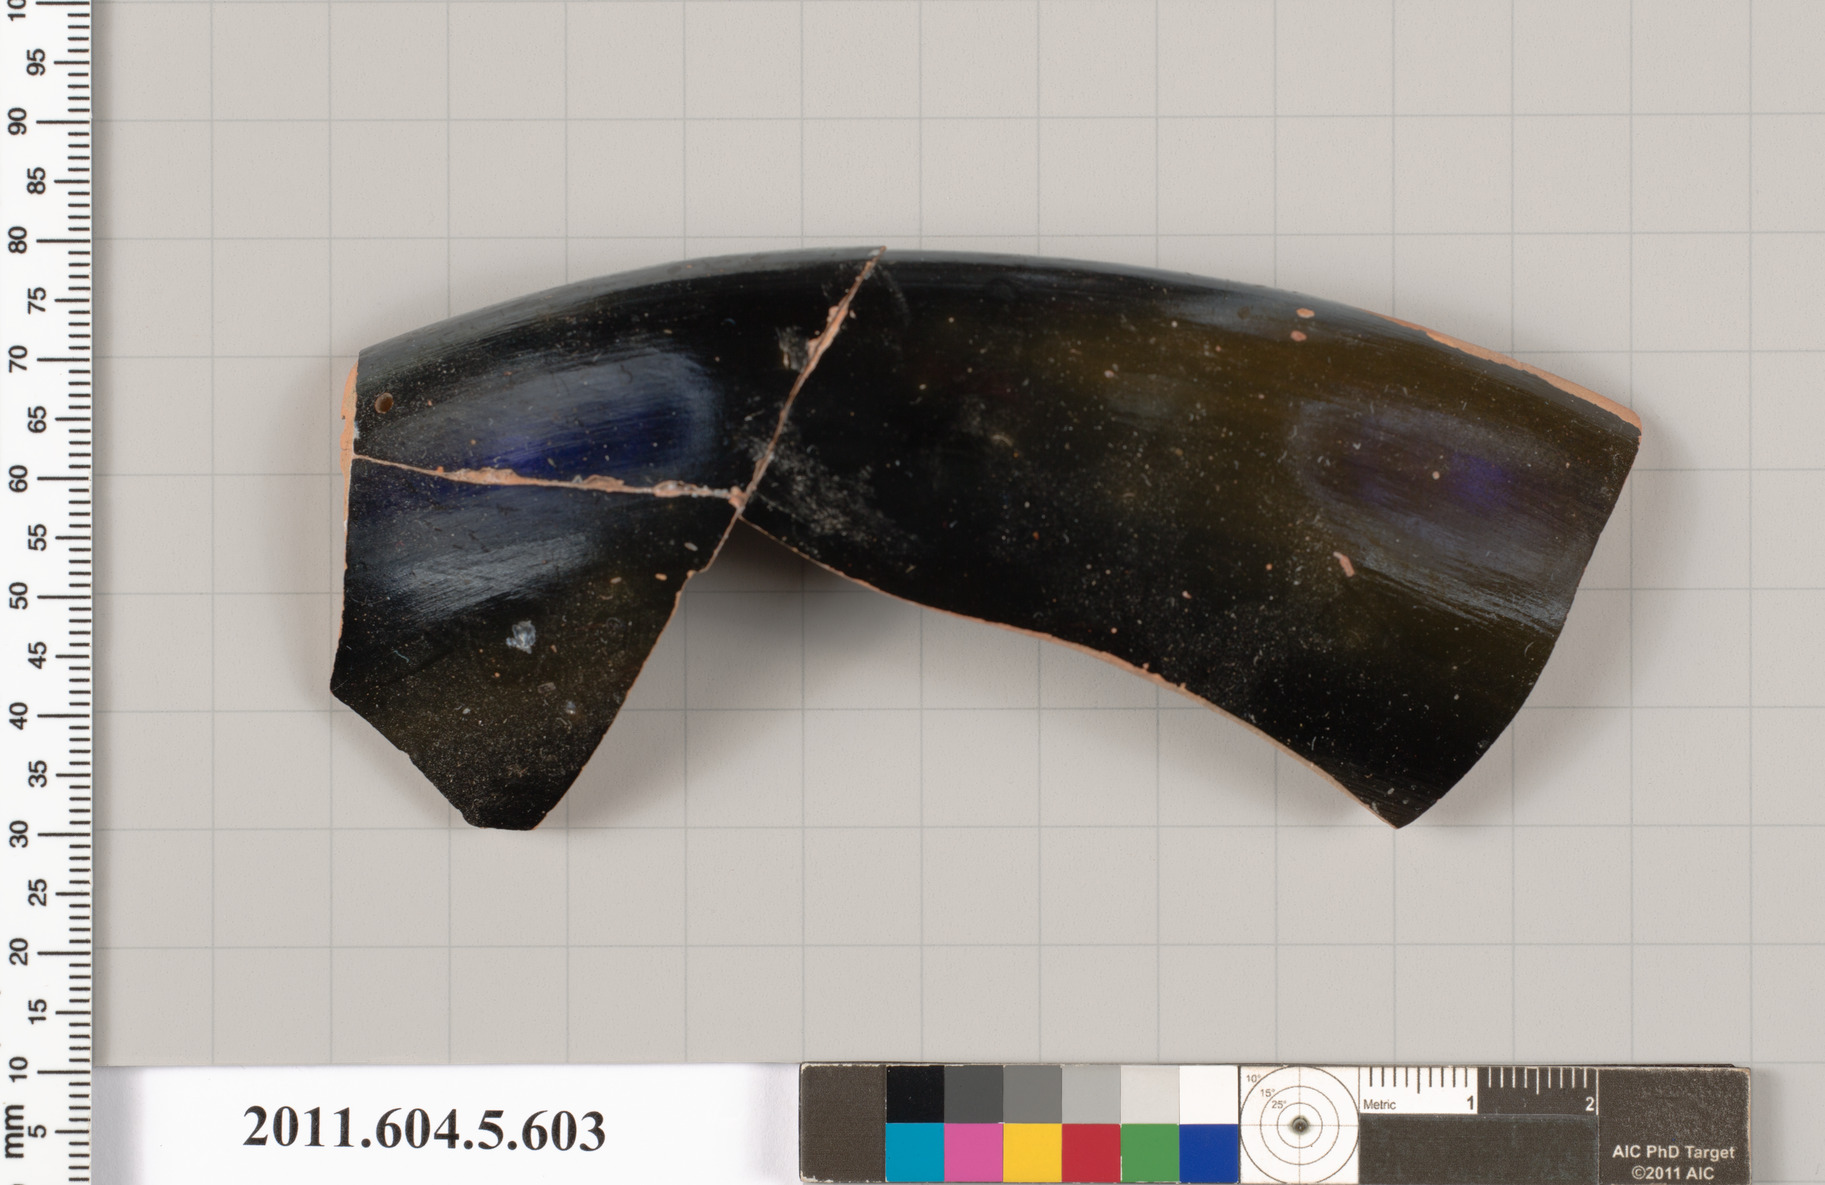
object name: kylix fragment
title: Terracotta rim fragment of a kylix (drinking cup)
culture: greek, attic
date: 600-401 BCE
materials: terracotta